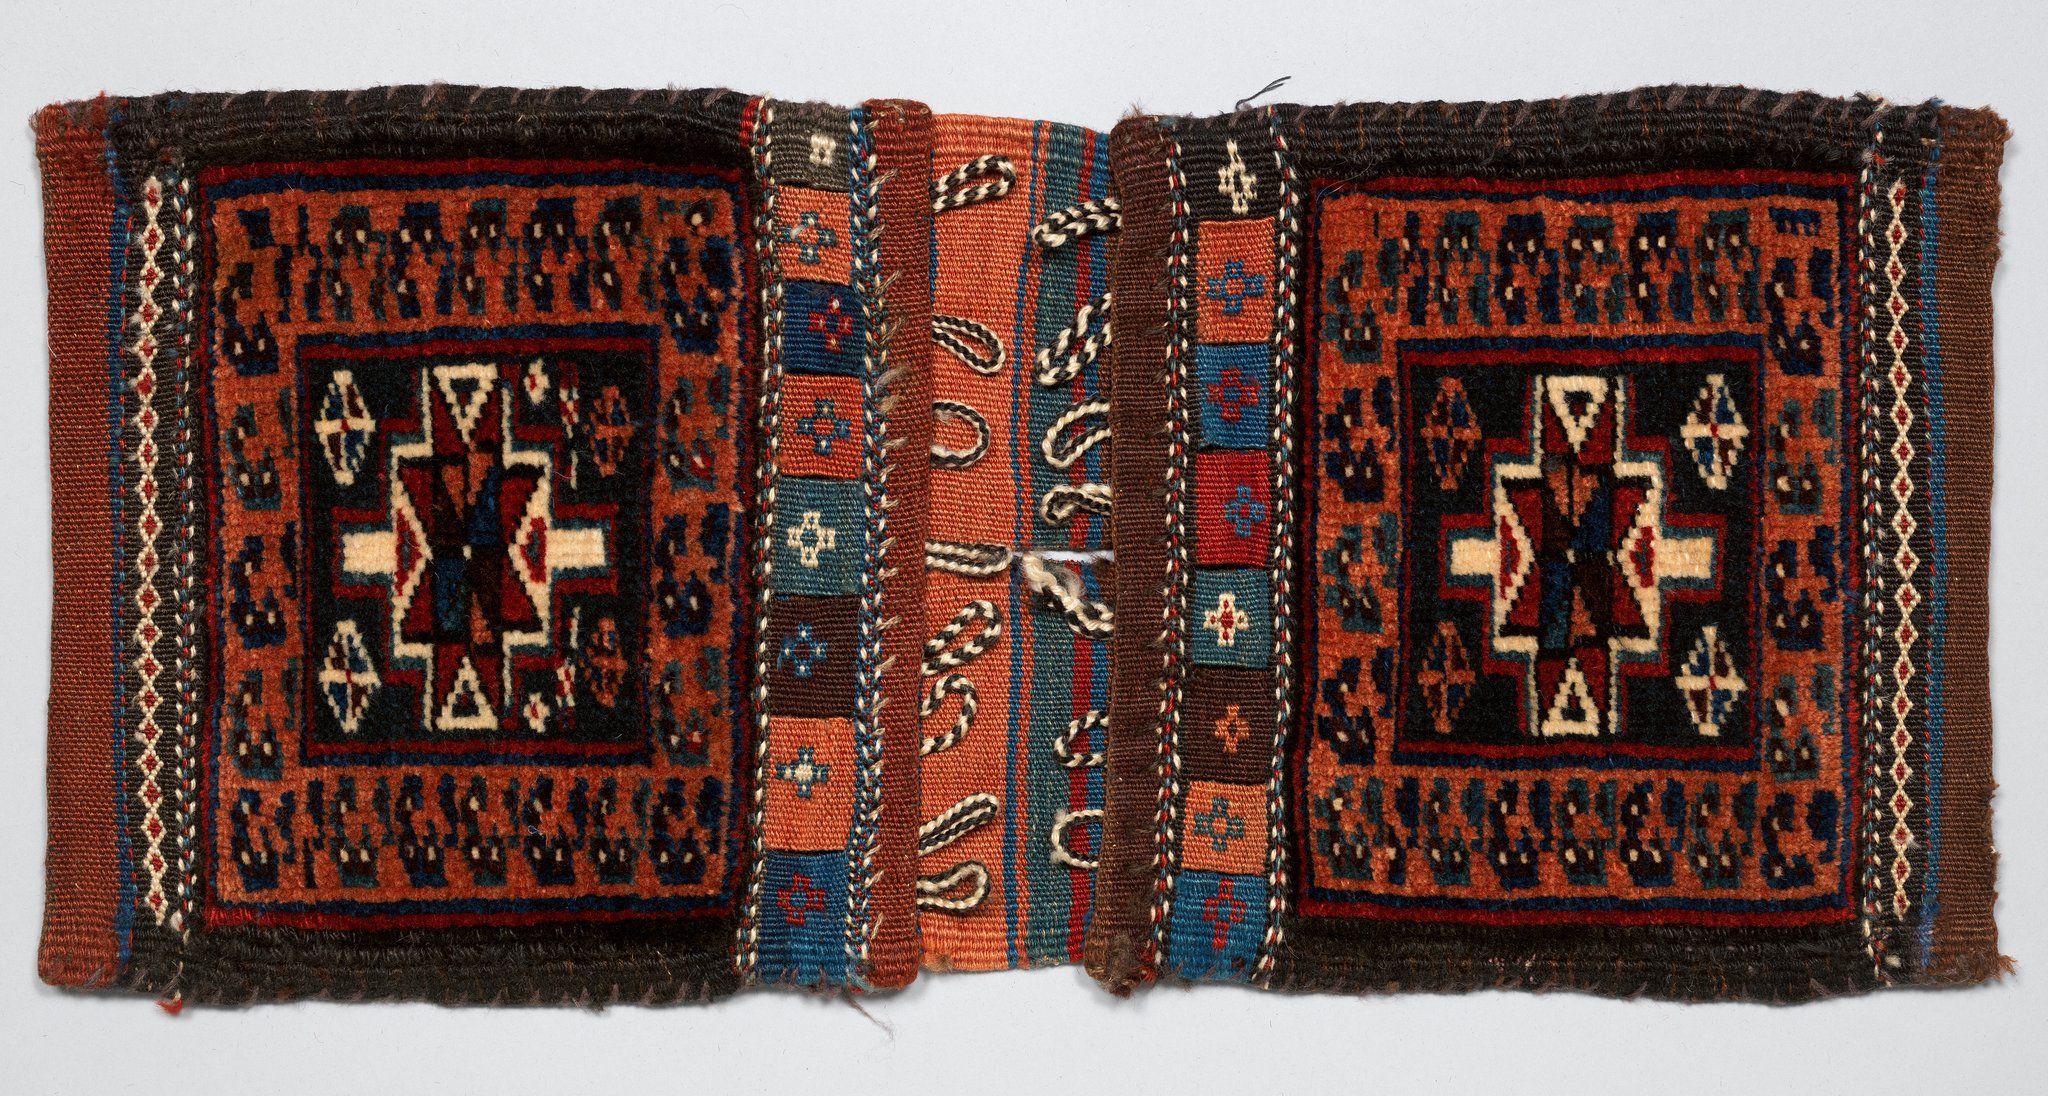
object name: saddle bag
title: Half of Double Saddle Bag (Khorjin)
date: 1900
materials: wool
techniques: asymmetrically knotted pile, brocade, weave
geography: iran